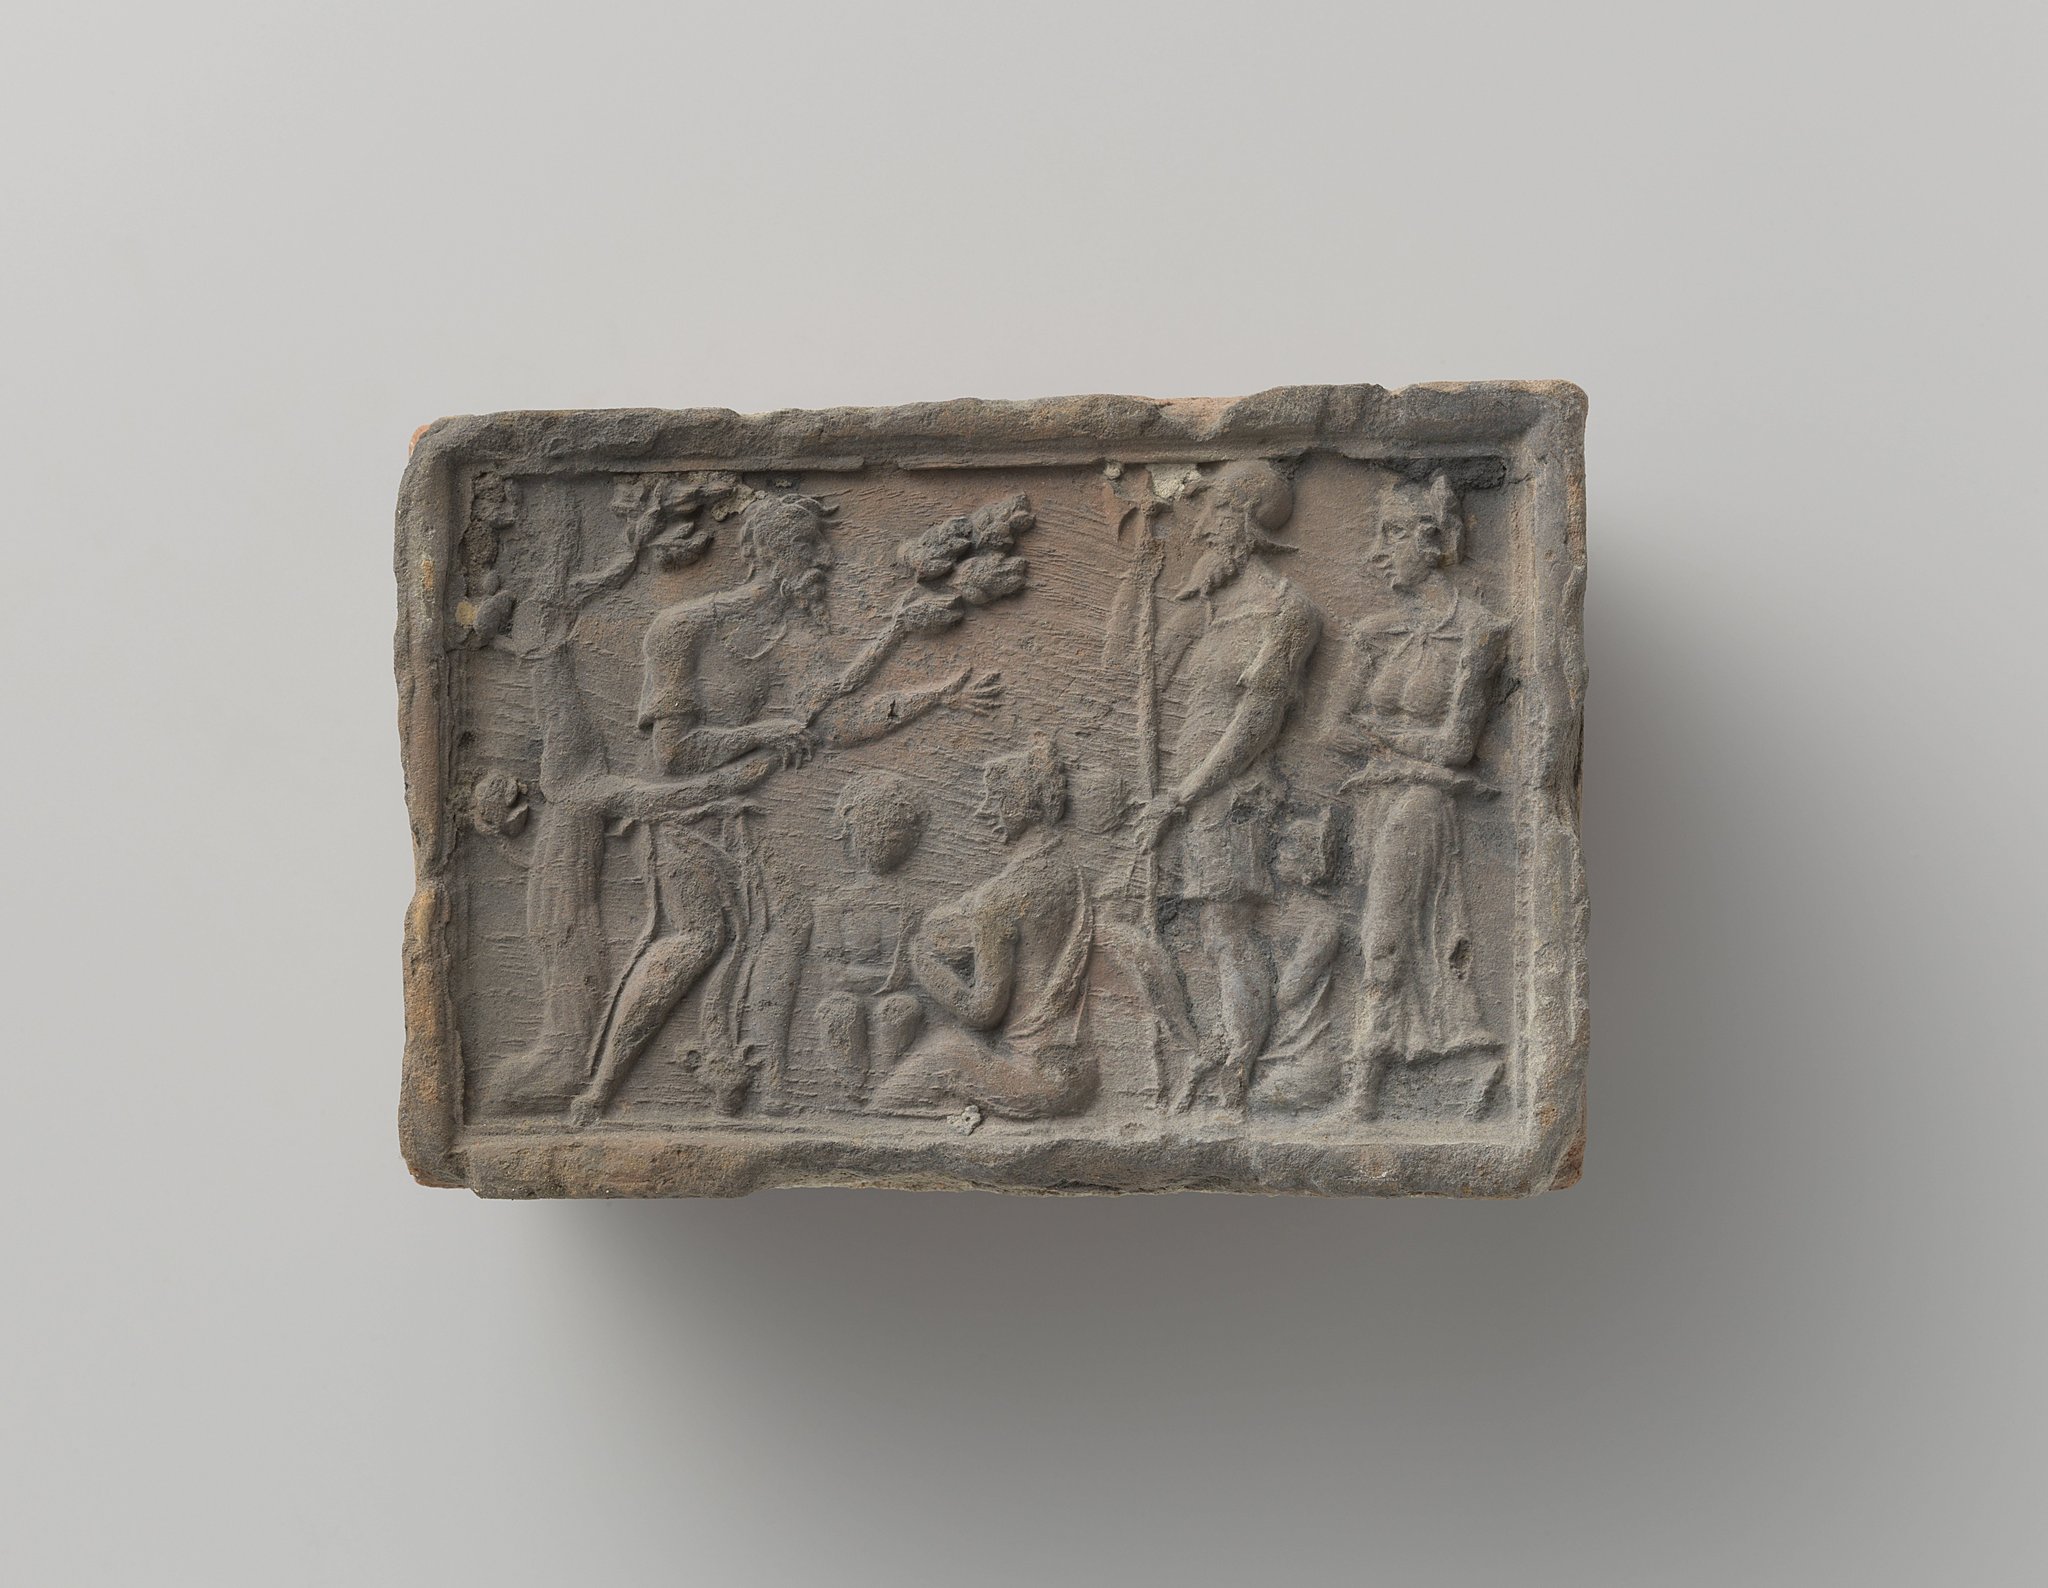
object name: architectural element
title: Haardsteen met voorstelling van Johannes de Doper, predikend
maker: Anonymous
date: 1525-1575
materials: earthenware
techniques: firing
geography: southern netherlands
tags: john the baptist preaching (perhaps christ among the bystanders)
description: Haardsteen met een voorstelling van Johannes de Doper, predikend bij een boom. Naast hem drie zittende en twee staande figuren